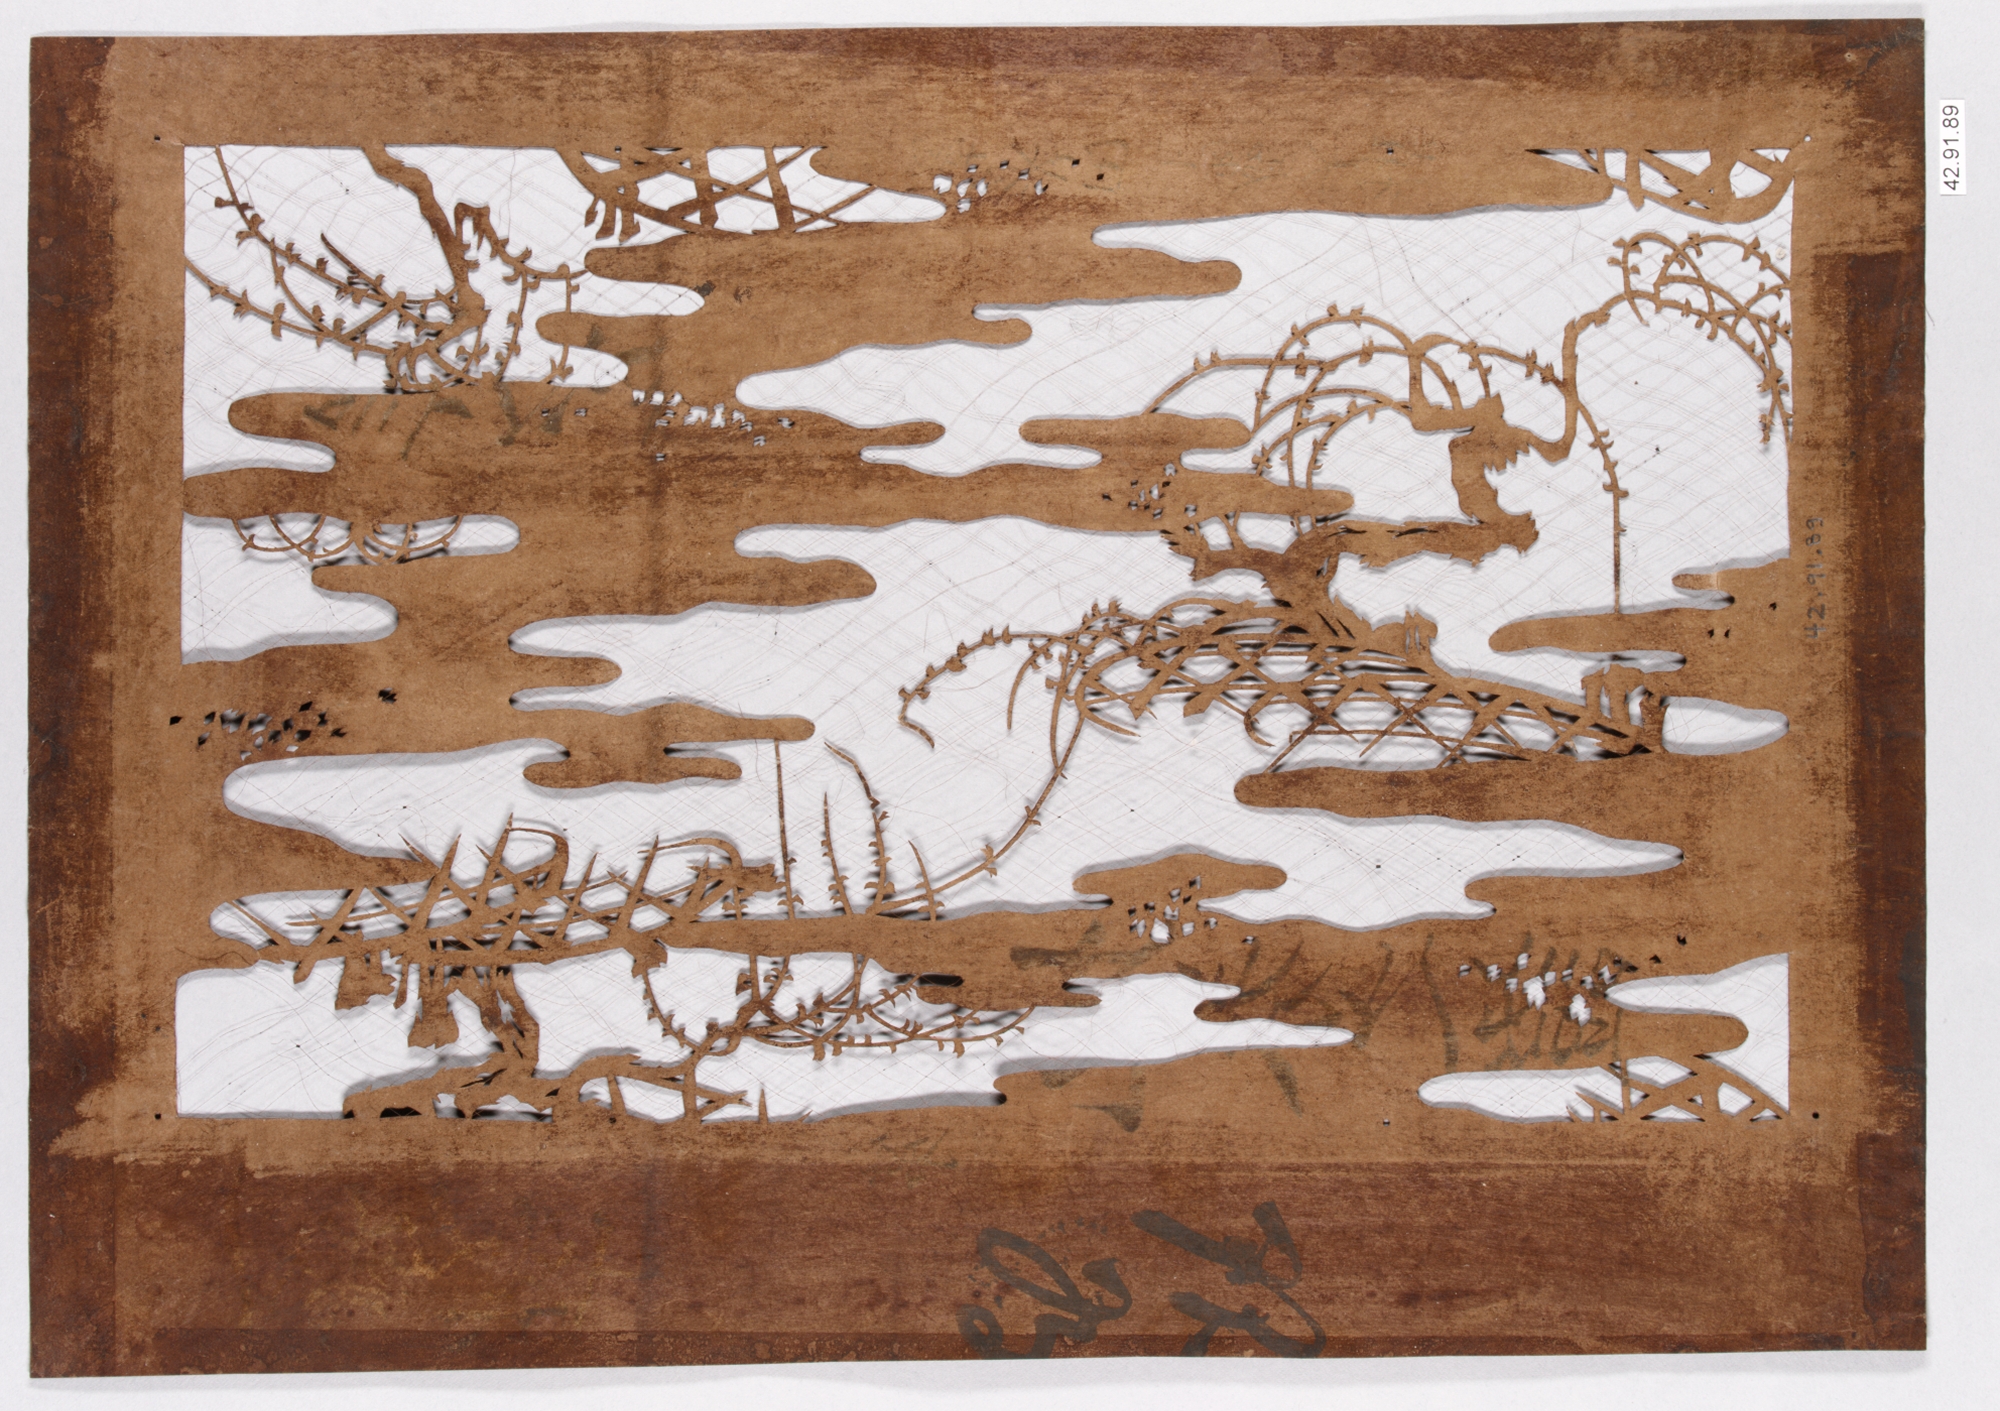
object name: stencil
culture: japanese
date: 1801-1900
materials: paper, silk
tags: trees